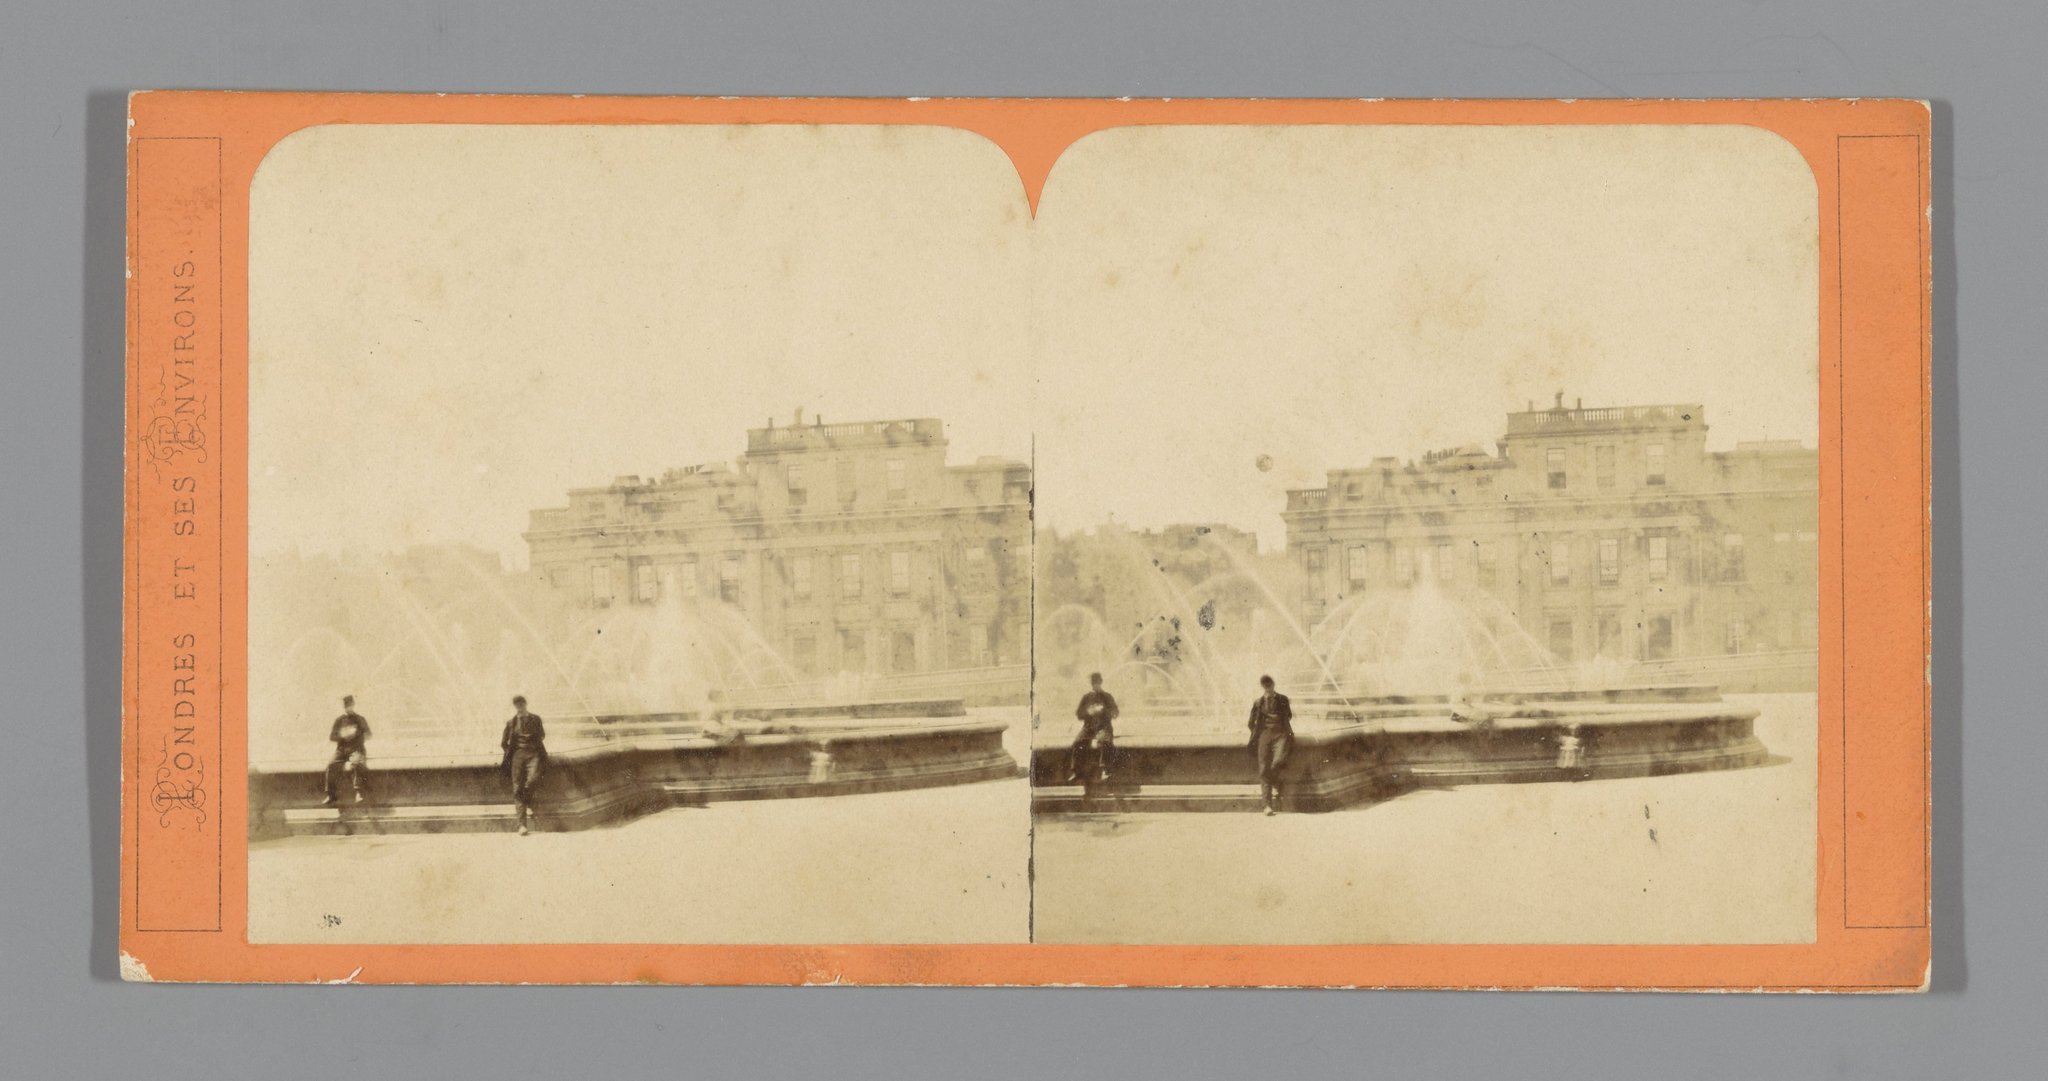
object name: stereograph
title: Londres et ses Environs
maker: Anonymous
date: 1850-1880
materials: cardboard, photographic support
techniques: albumen print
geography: trafalgar square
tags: ornamental fountain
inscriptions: inscription: ‘Jets-d'eau de Trafalgar Square’